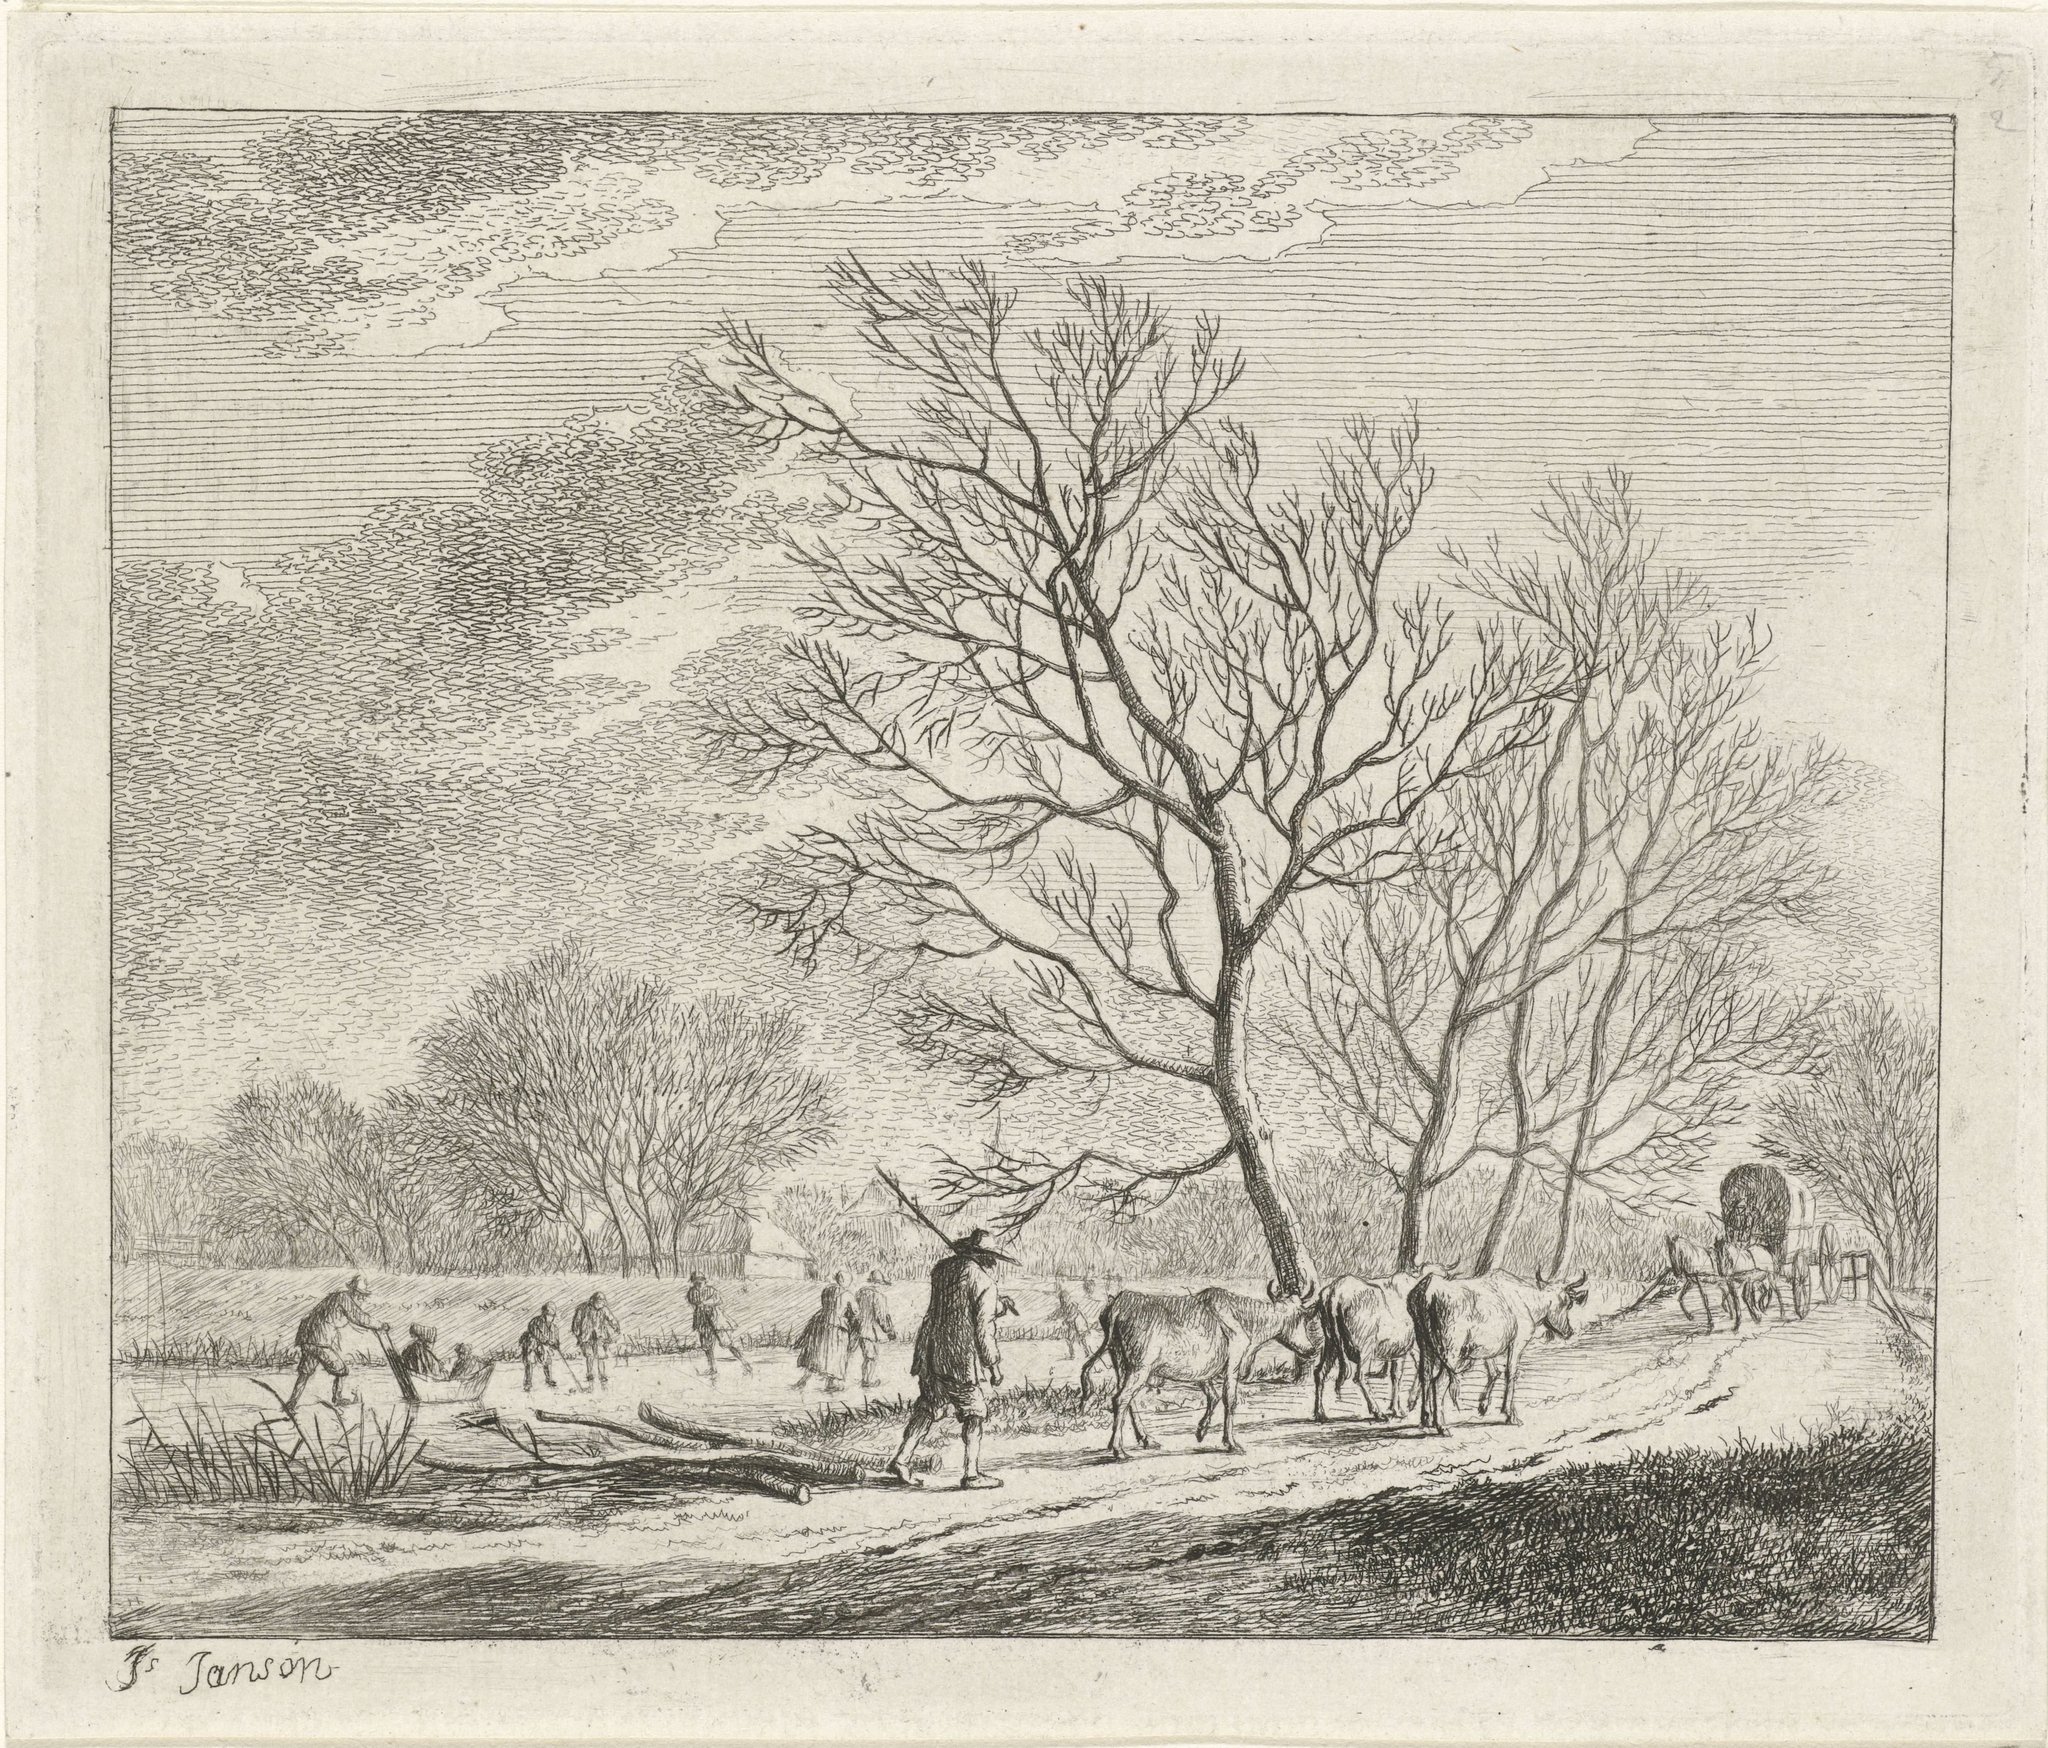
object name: print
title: Winterlandschap met koeien en schaatsers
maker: johannes janson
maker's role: draughtsman, painter, print maker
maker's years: 1729-1784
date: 1783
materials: paper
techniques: etching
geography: leiden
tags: landscape symbolizing december, winter ~ human activities (the four seasons of the year)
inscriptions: collector's mark: Lugt 2228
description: Winterlandschap met herder met drie koeien op een pad, op de rug gezien. Een huifkar komt hen tegemoet. Links schaatsers op een bevroren rivier. Dertiende prent uit een serie van dertien met maanden.